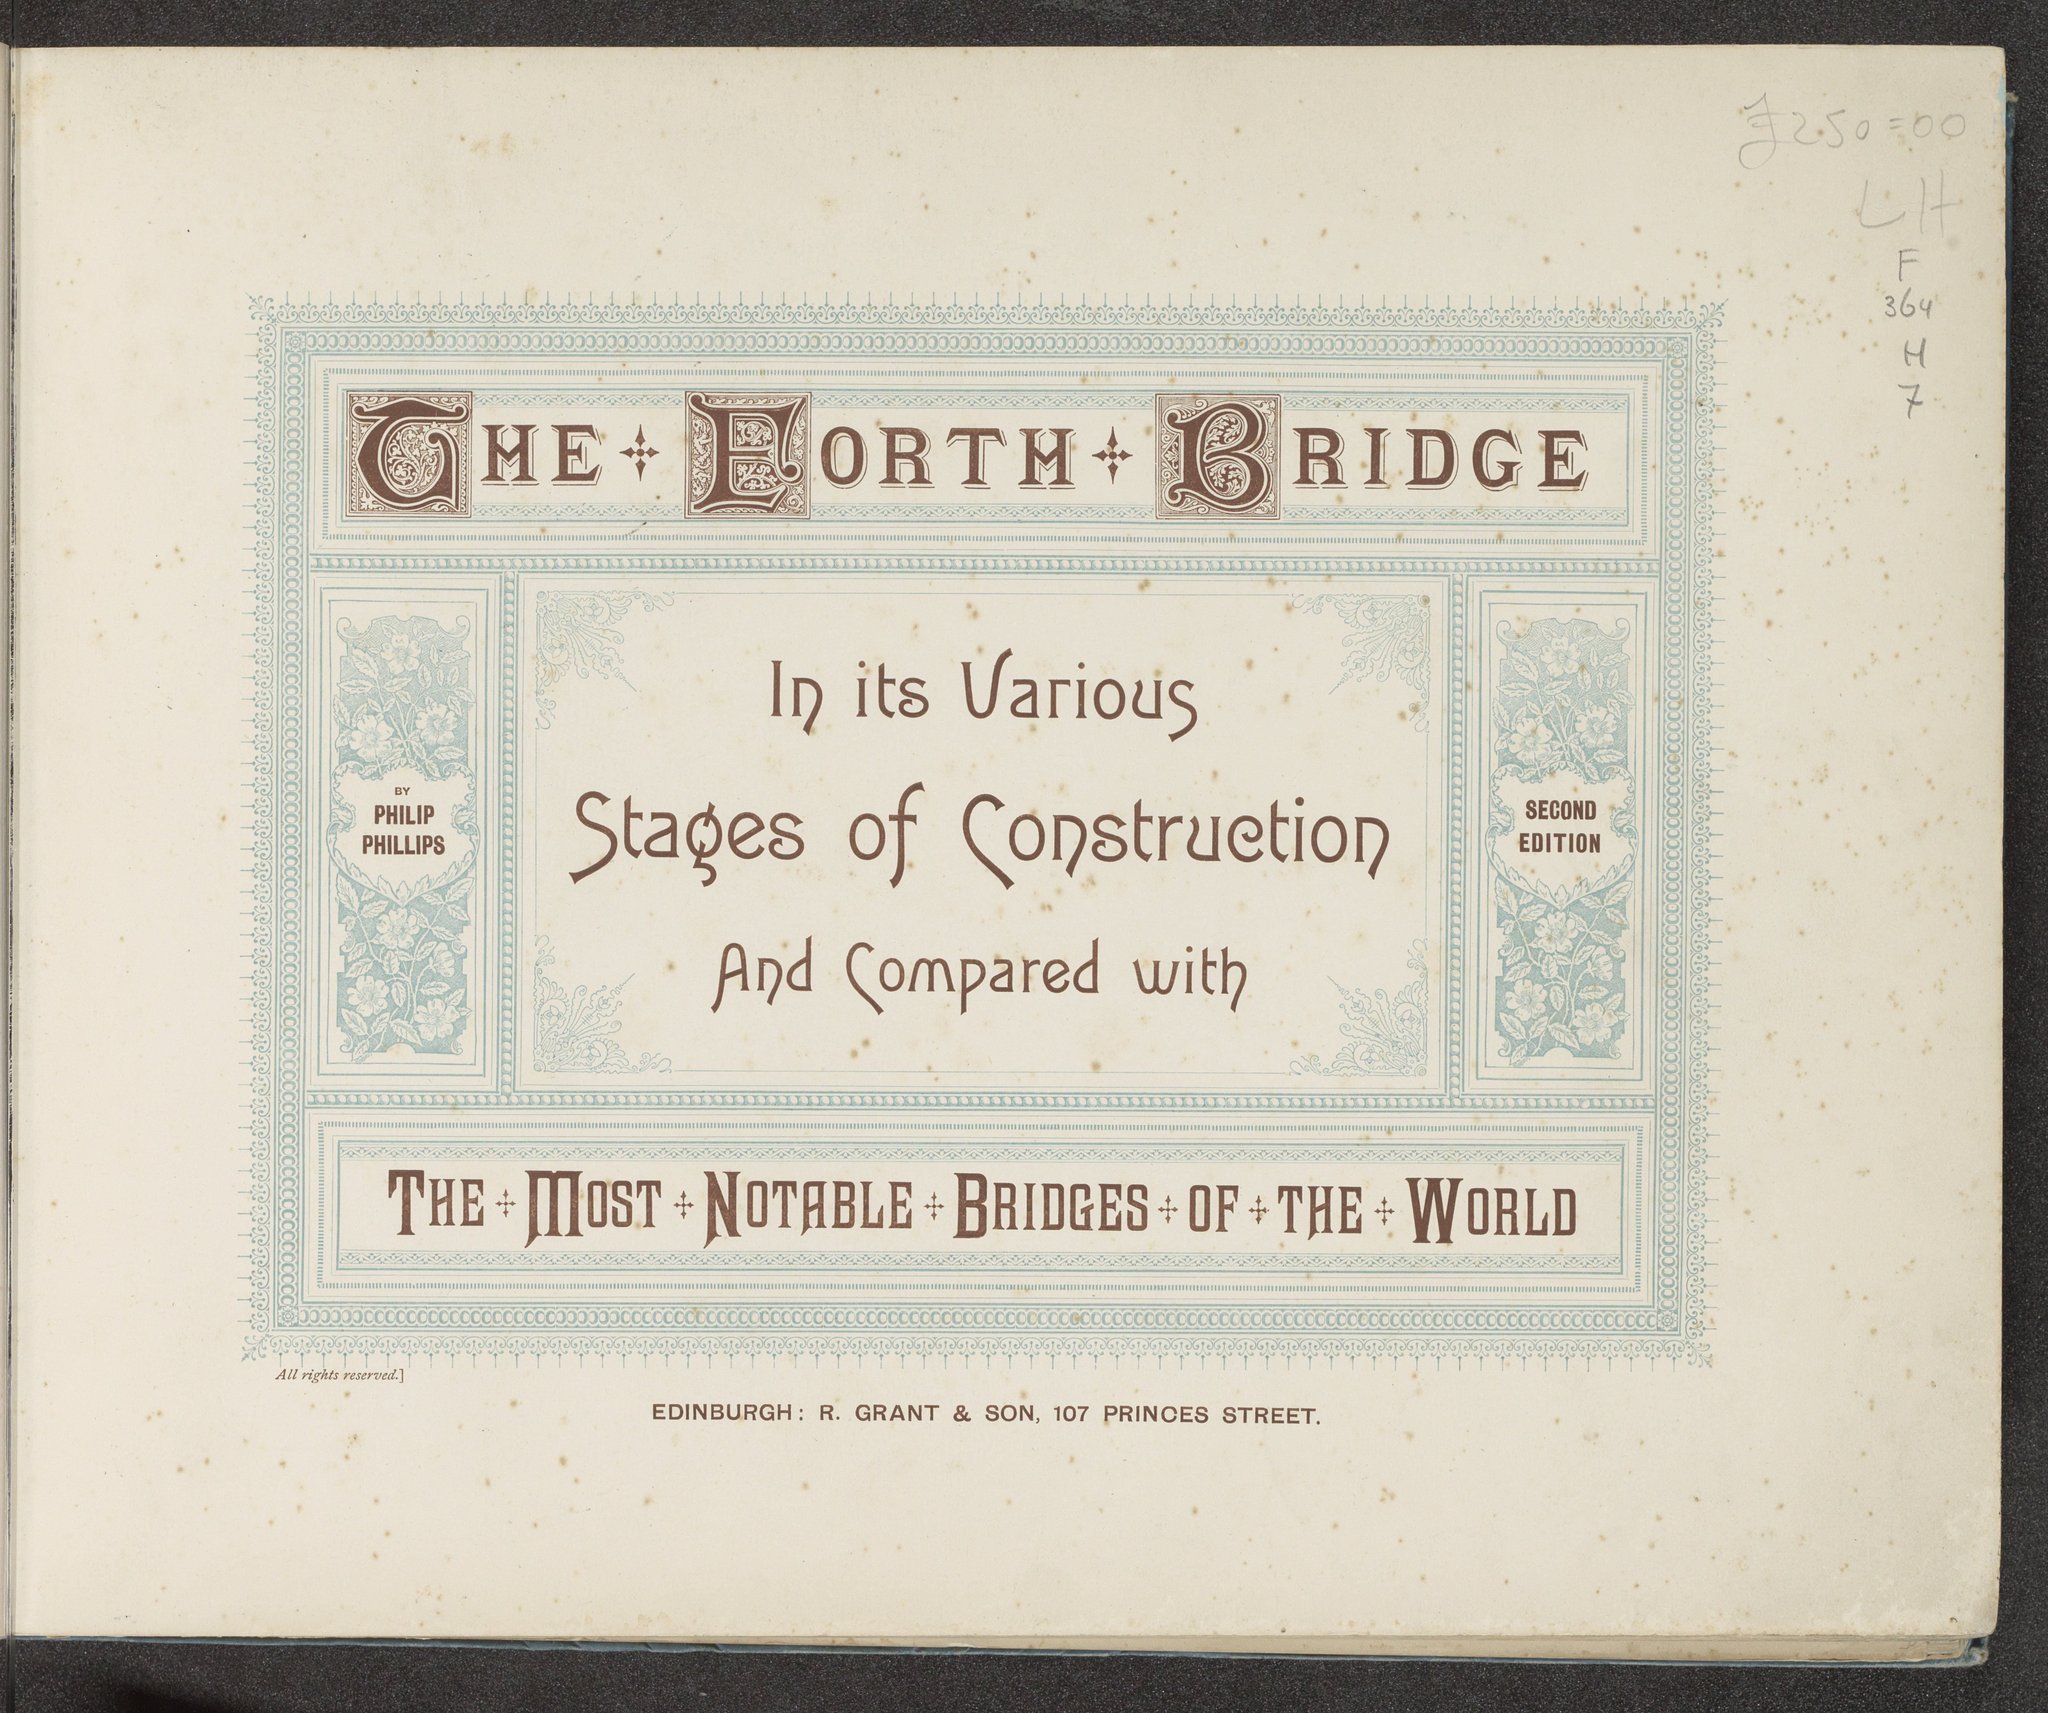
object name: book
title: The Forth Bridge in its various stages of construction and compared with the most notable bridges of the world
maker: philip phillips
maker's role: schrijver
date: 1890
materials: cardboard, linen, paper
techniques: photograph, printing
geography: edinburgh